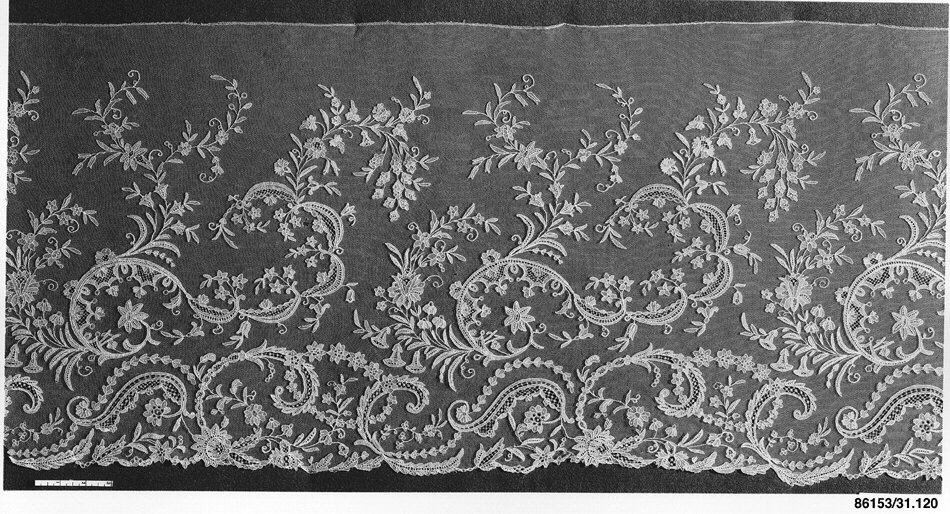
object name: flounce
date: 1801-1900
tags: flowers,leaves